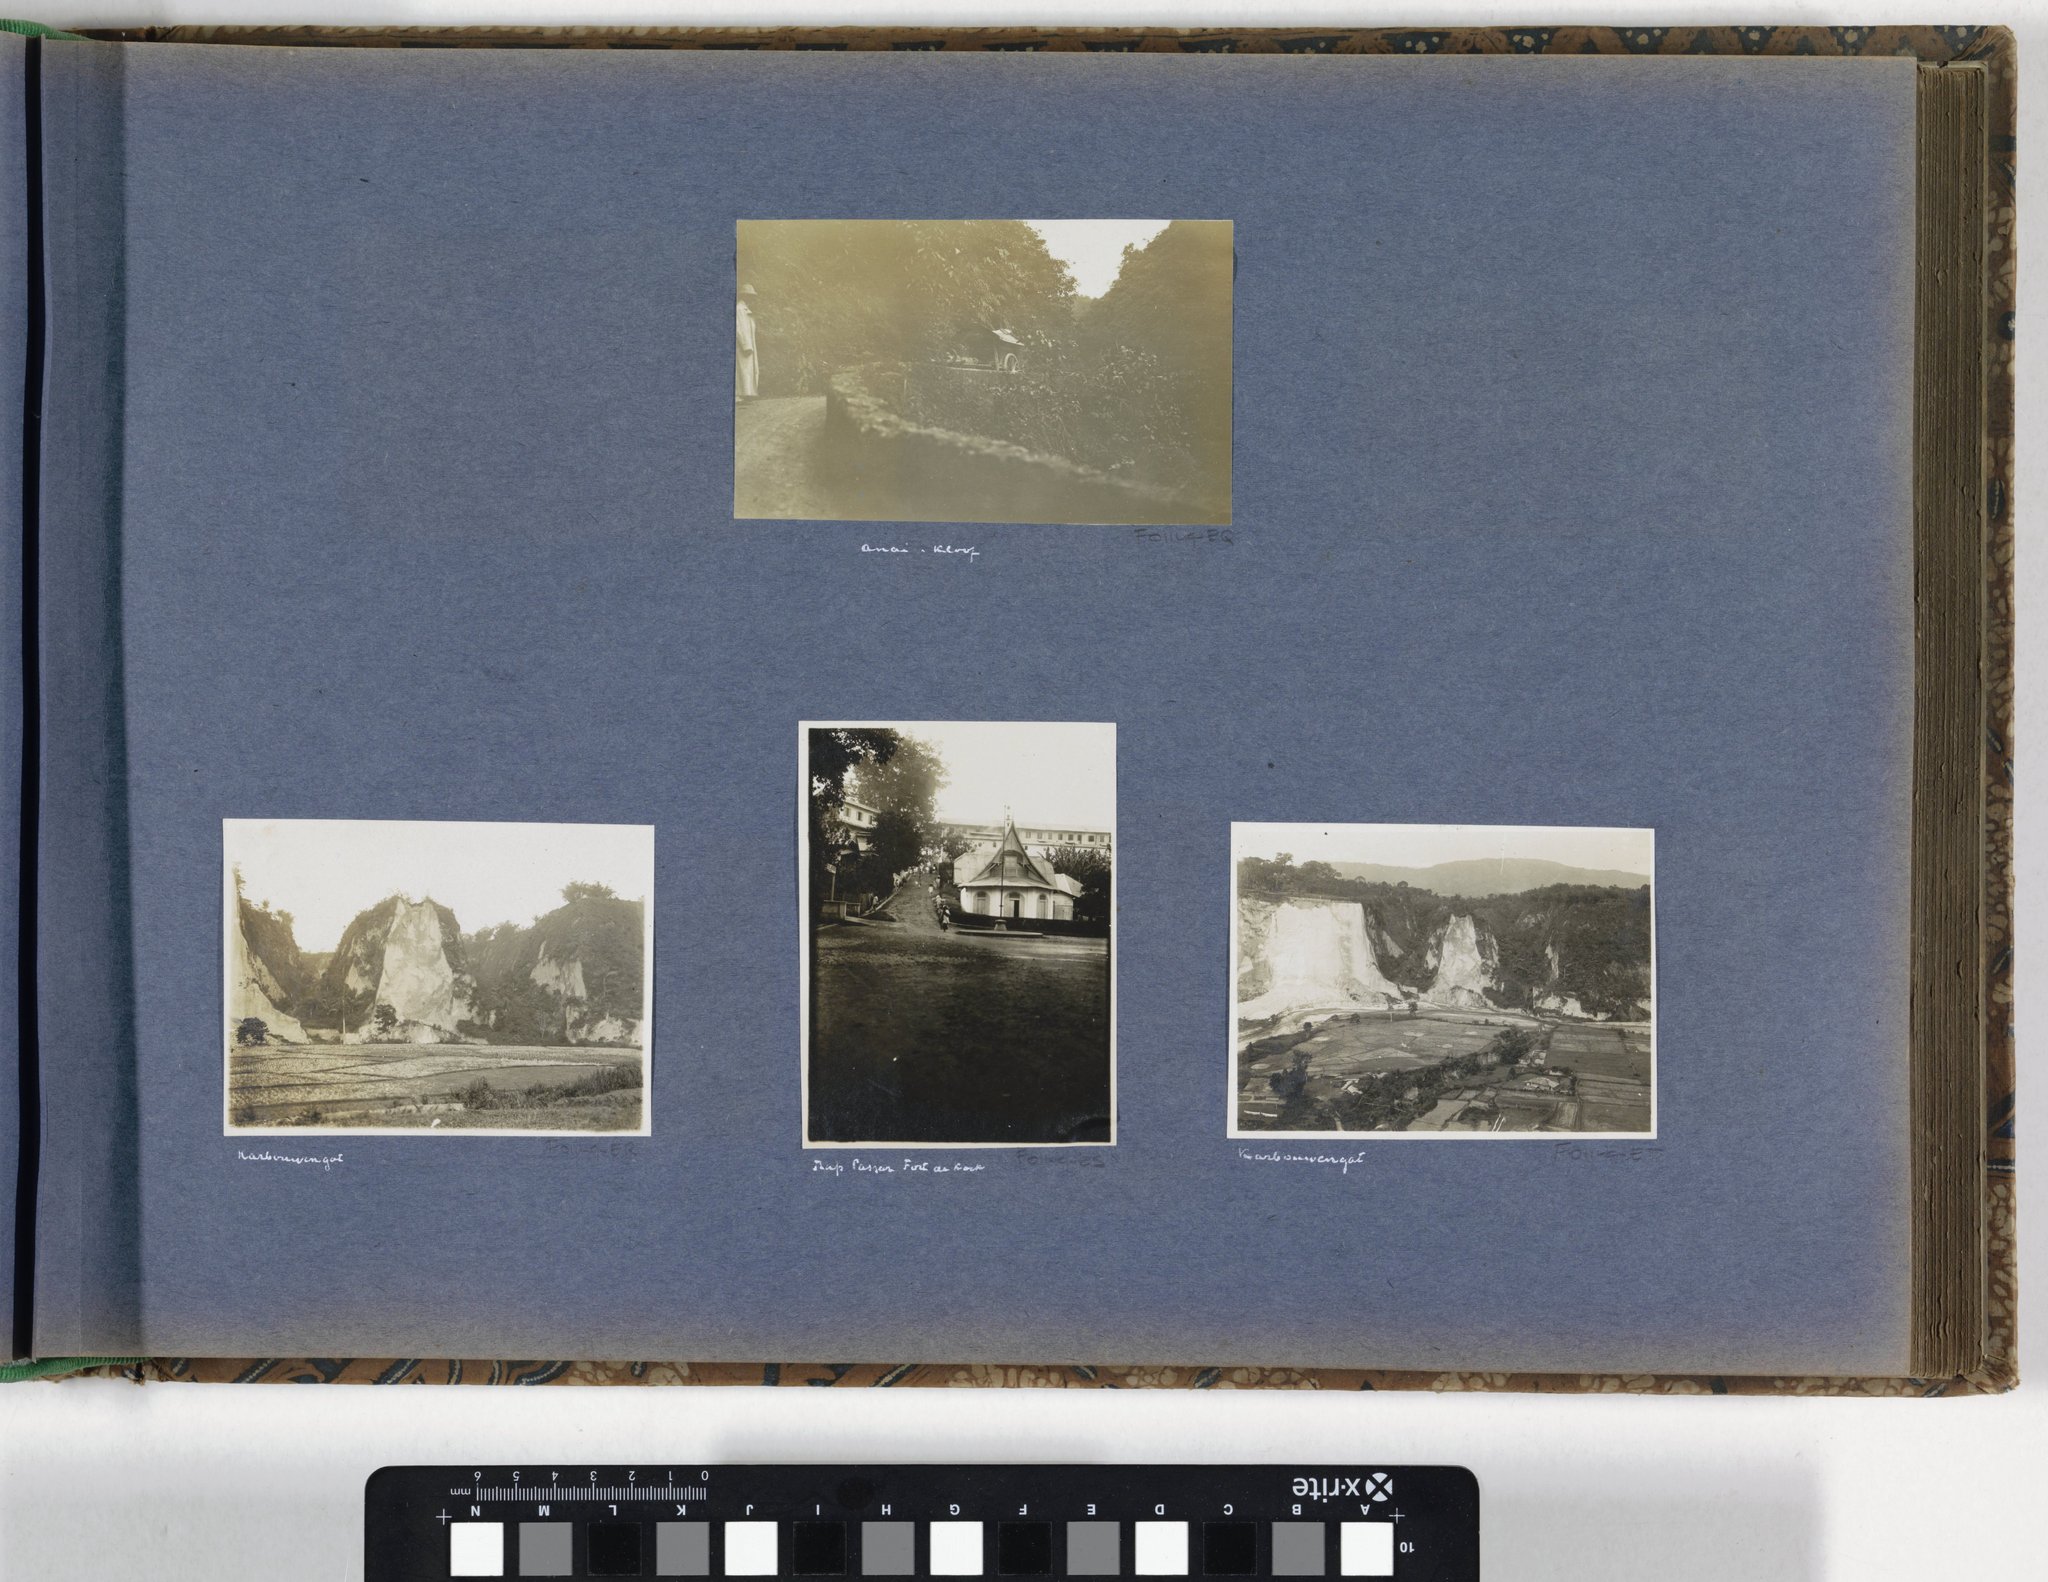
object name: album leaf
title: Velden en rotsformaties bij Karbouwengat op Sumatra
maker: Anonymous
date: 1900-1920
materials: paper, photographic support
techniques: gelatin silver print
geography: sumatra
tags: ravine, chasm, abyss, canyon, rock-formations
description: Onderdeel van reisalbum met foto's van bedrijvigheid en bezienswaardigheden op Sumatra en Java en van de reis naar en van Nederlands-Indië.